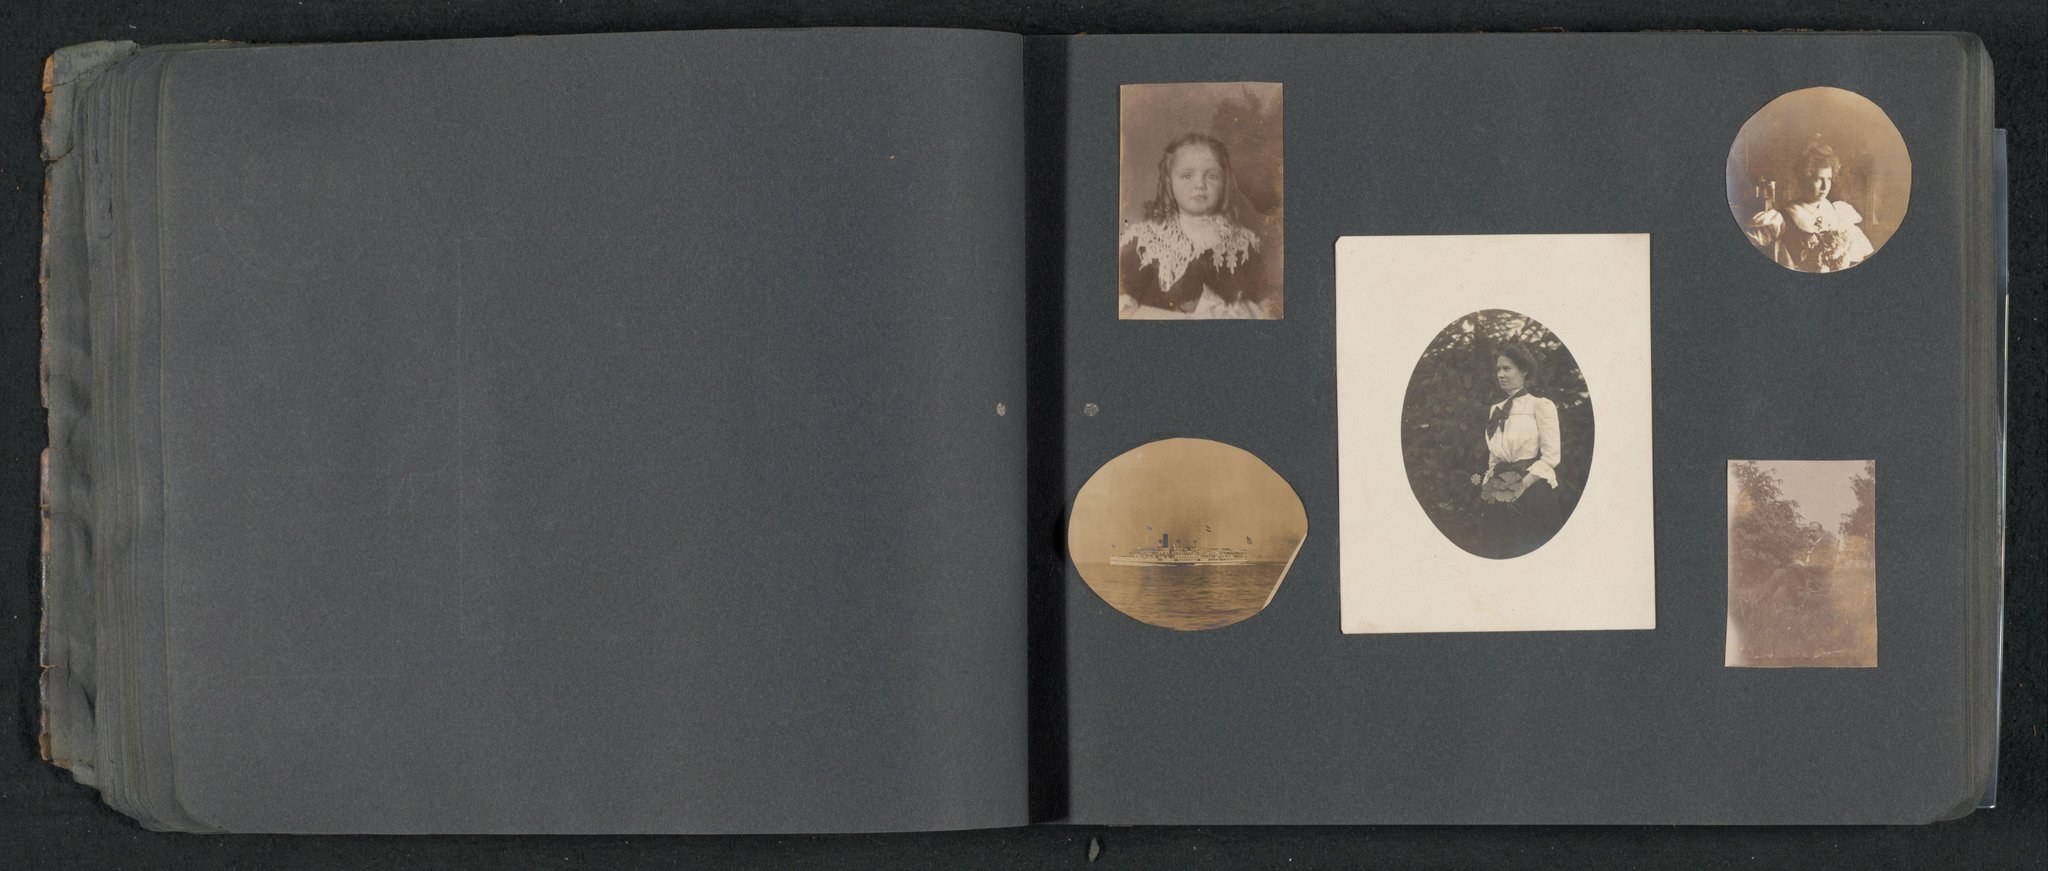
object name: photograph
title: Man, vrouw, kind en schip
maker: Anonymous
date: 1890-1902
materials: paper, photographic support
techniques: gelatin silver print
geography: united states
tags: historical persons, united states of america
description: Albumblad met vijf foto's van een jong kind, van een vrouw in een jurk, een man zittend in een tuinstoel en van een passagiersschip op open water. Onderdeel van Familiealbum met voornamelijk foto's van een jong Amerikaans meisje.